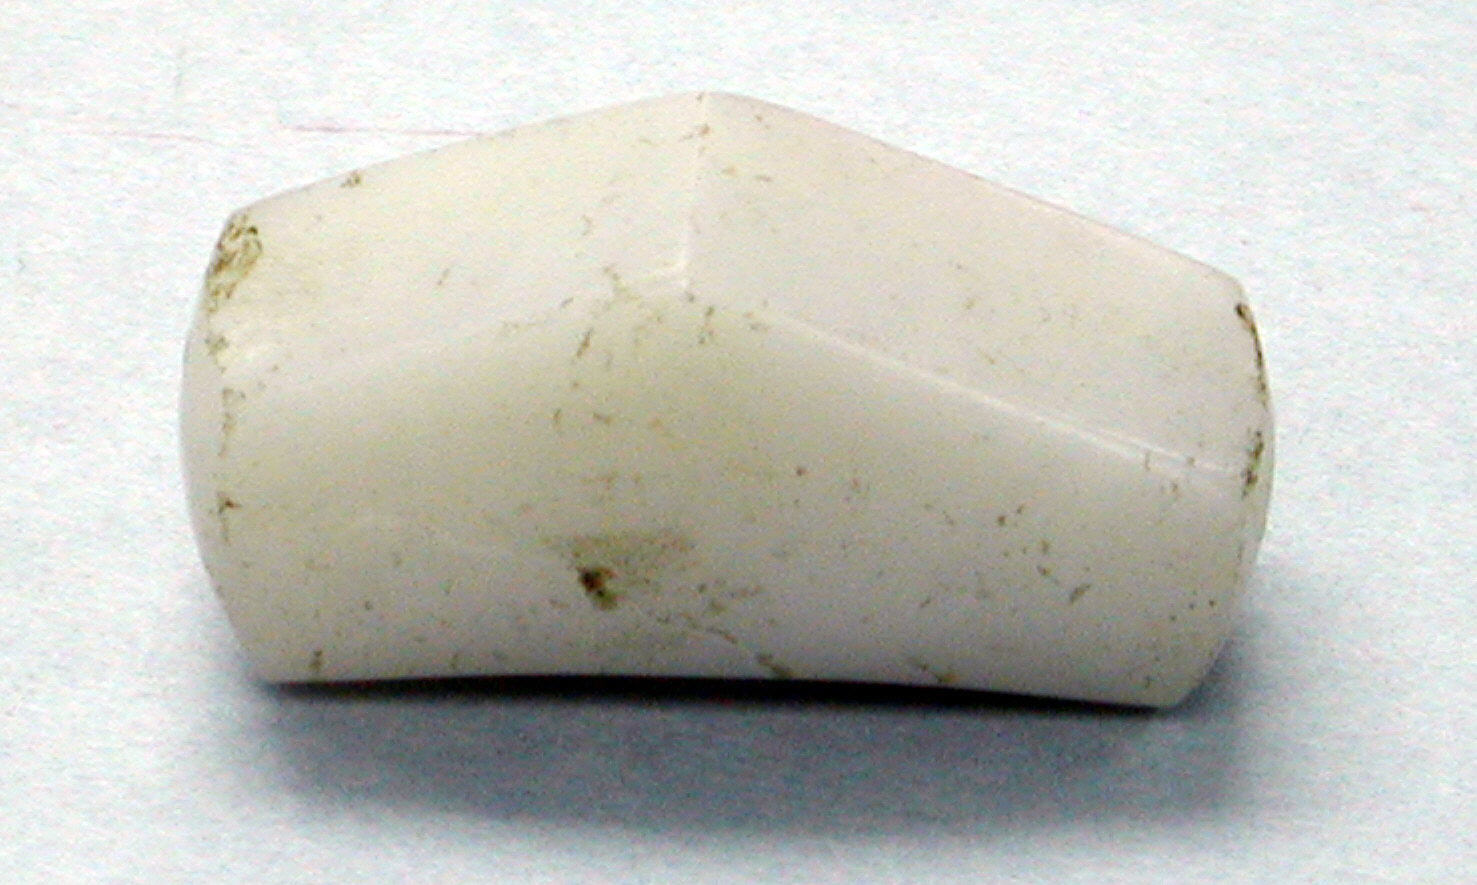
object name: ritual stone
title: Stone Pulidor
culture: mexican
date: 1501-1600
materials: stone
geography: mexico